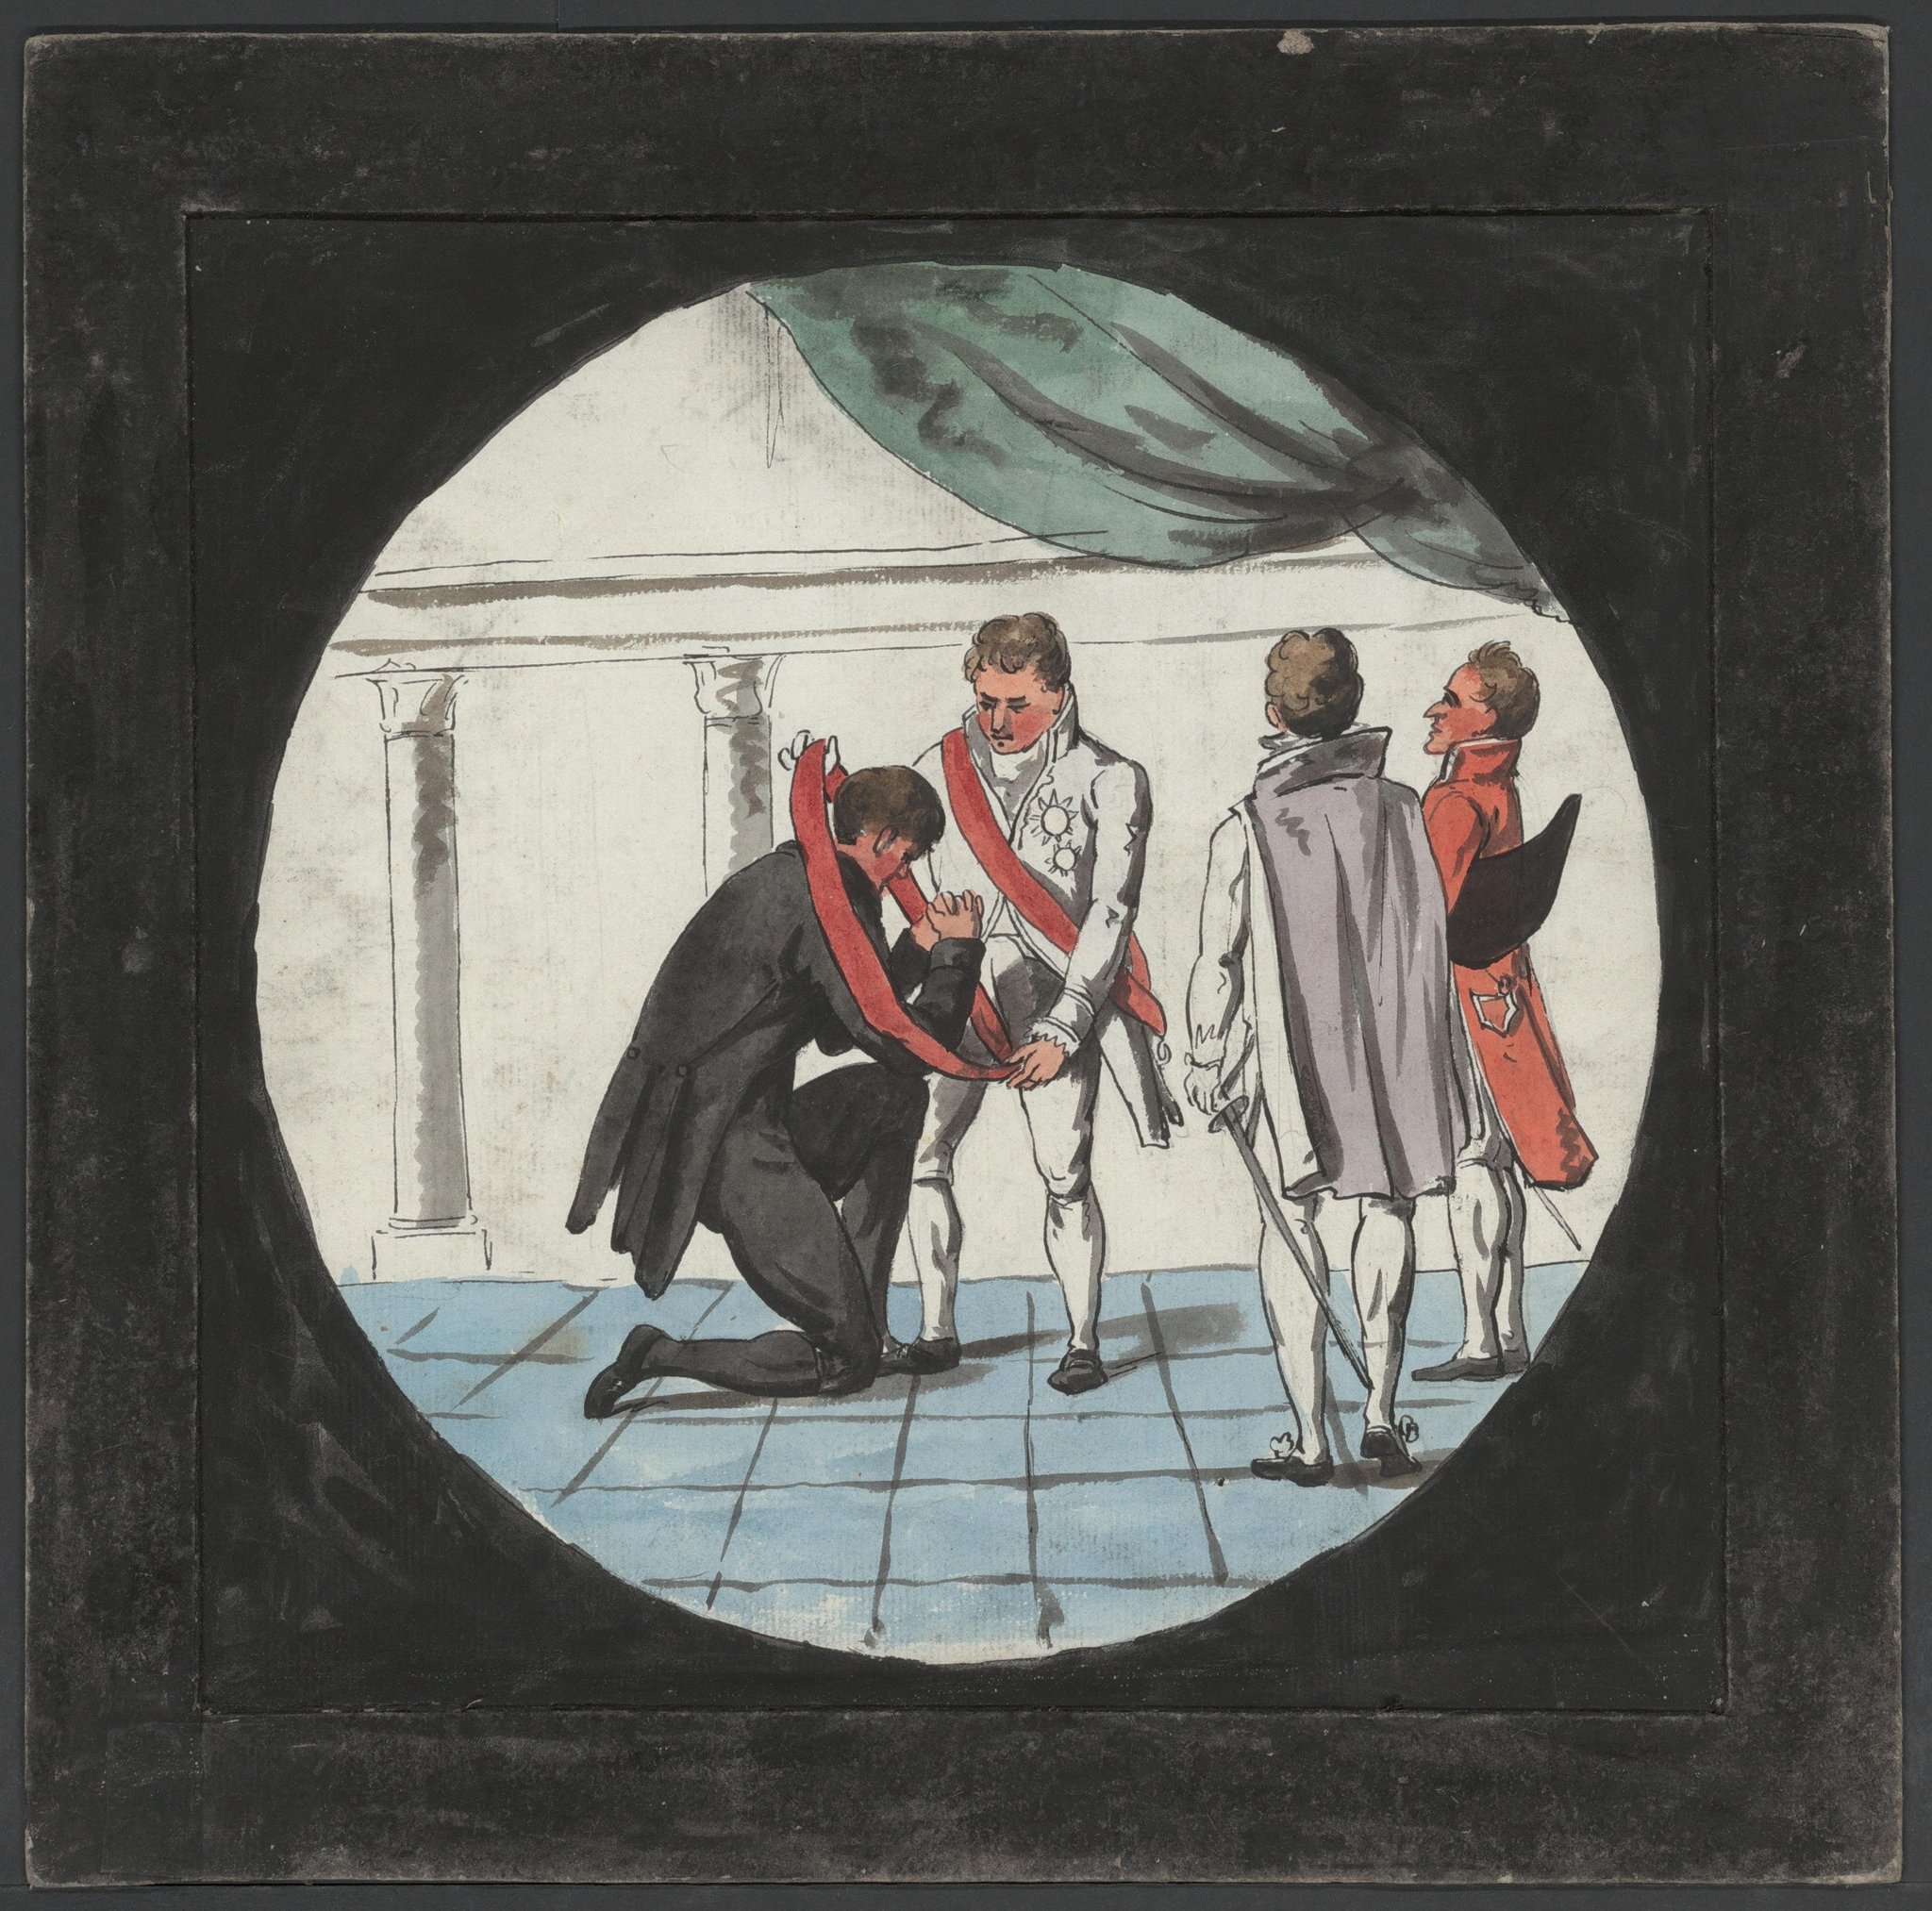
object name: drawing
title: Uitreiken van een onderscheiding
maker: jacob willemz. de vos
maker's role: draughtsman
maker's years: 1774-1844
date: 1800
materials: cardboard, ink, paper, watercolor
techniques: brush, pen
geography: netherlands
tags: physician, doctor, kneeling figure, official acts of rulers, e.g. royal acts (ruler giving audience, granting mercy, etc.; ruler and his subjects)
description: Een geknielde jongeman krijgt een rode sjerp omgehangen door een andere man die eveneens een rode sjerp draagt. Rechts kijken twee mannen toe. De geknielde jongeman is mogelijk Daniel Dijlius, arts te Amsterdam. Onderdeel van een serie van elf ronde tekeningen die mogelijk als toverlantaarnplaat zijn gemaakt.